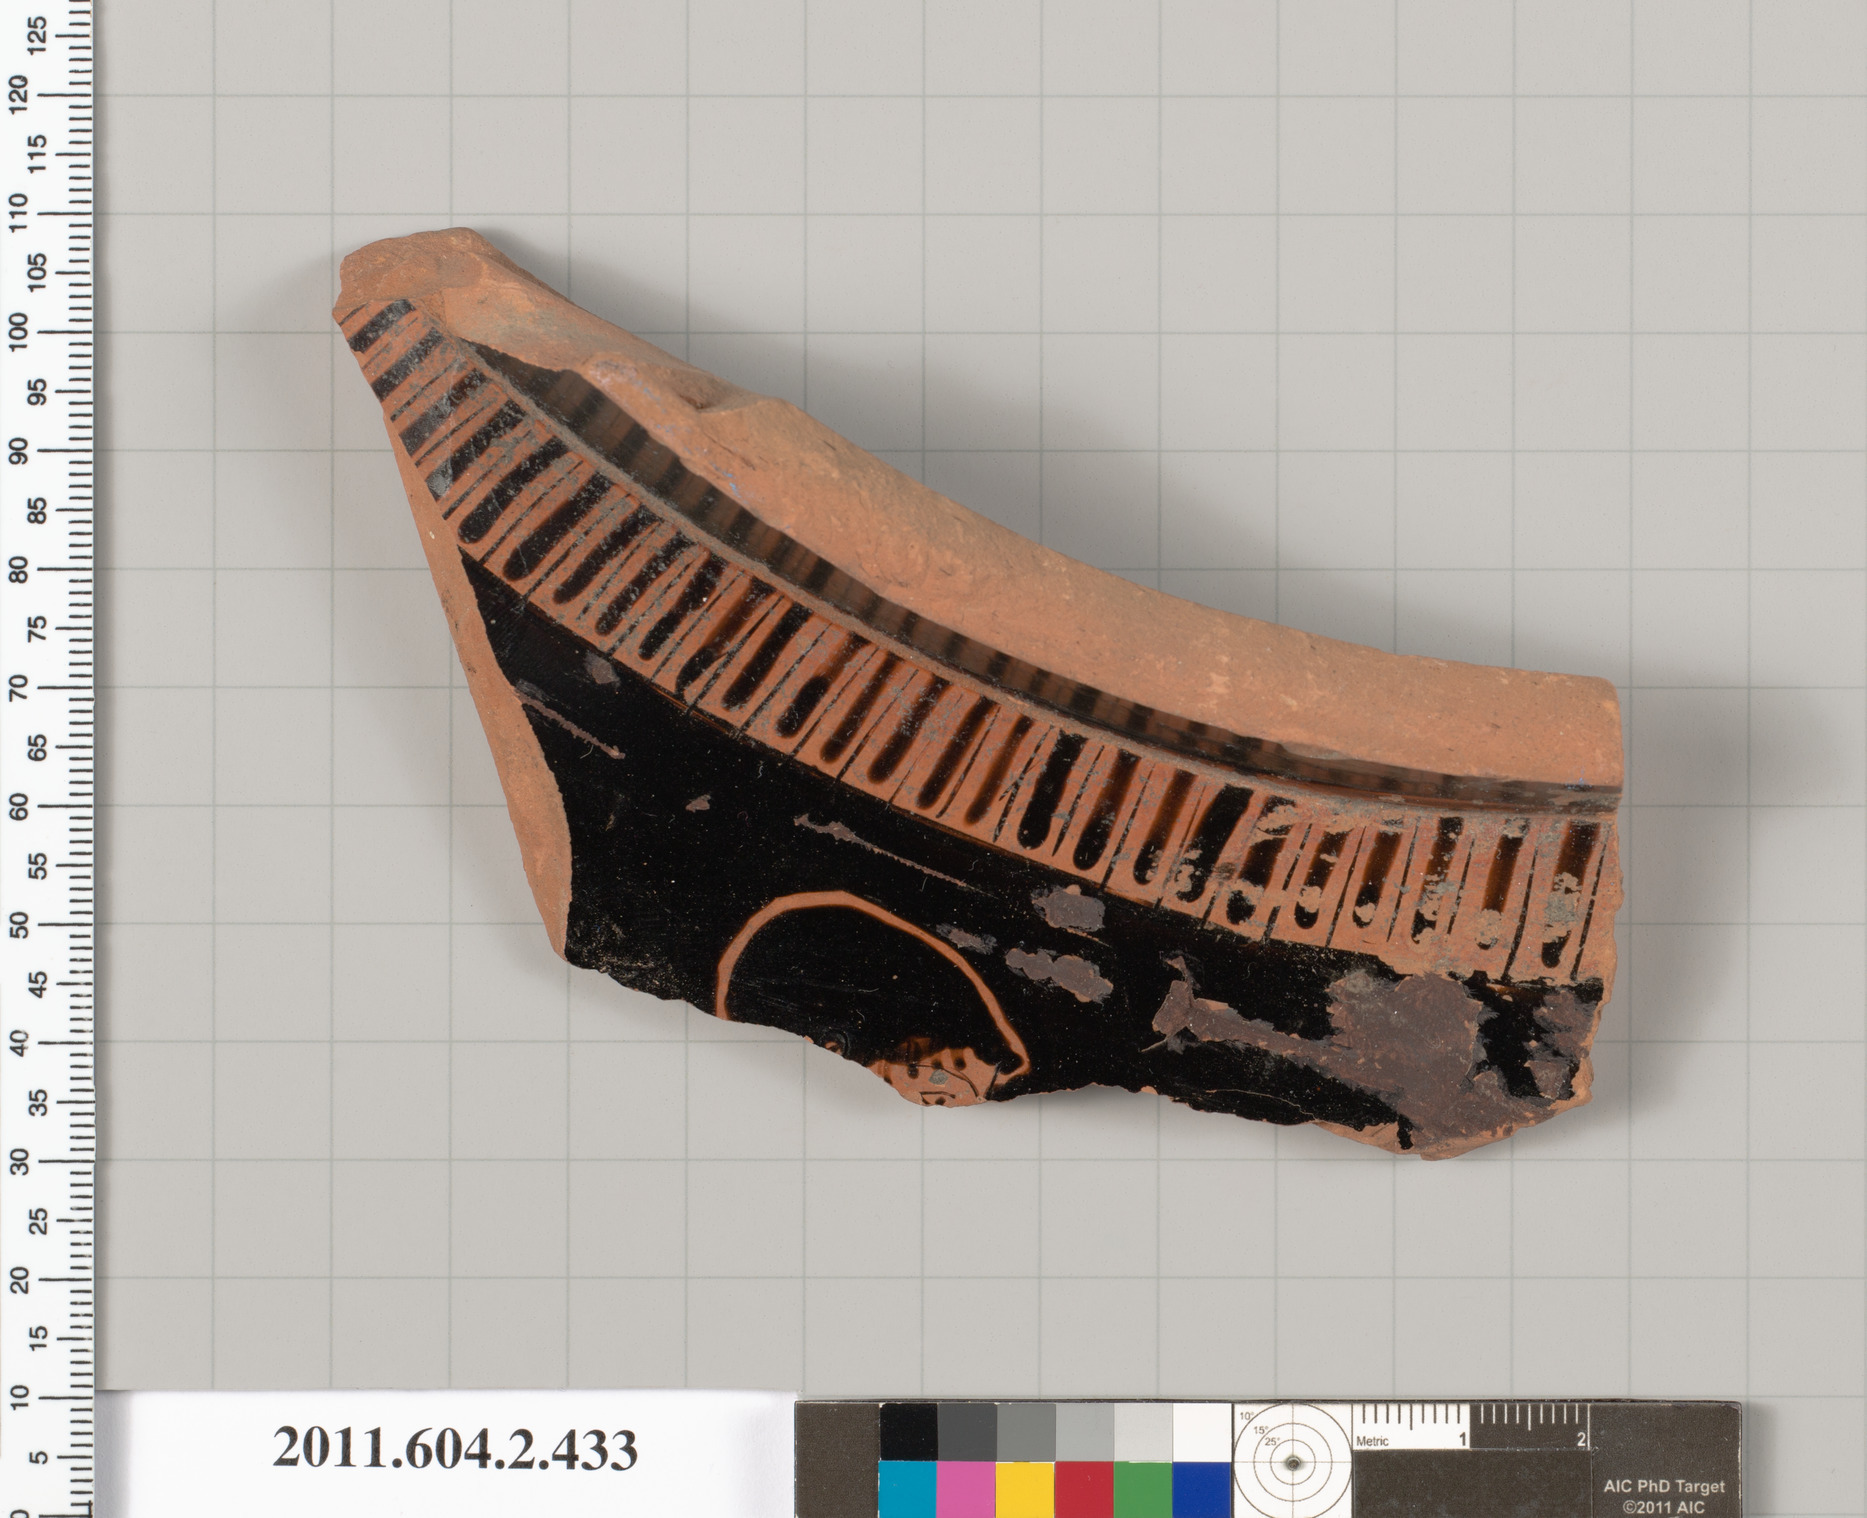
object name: stamnos fragment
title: Terracotta fragment of a stamnos (jar)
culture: greek, attic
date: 460-440 BCE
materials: terracotta